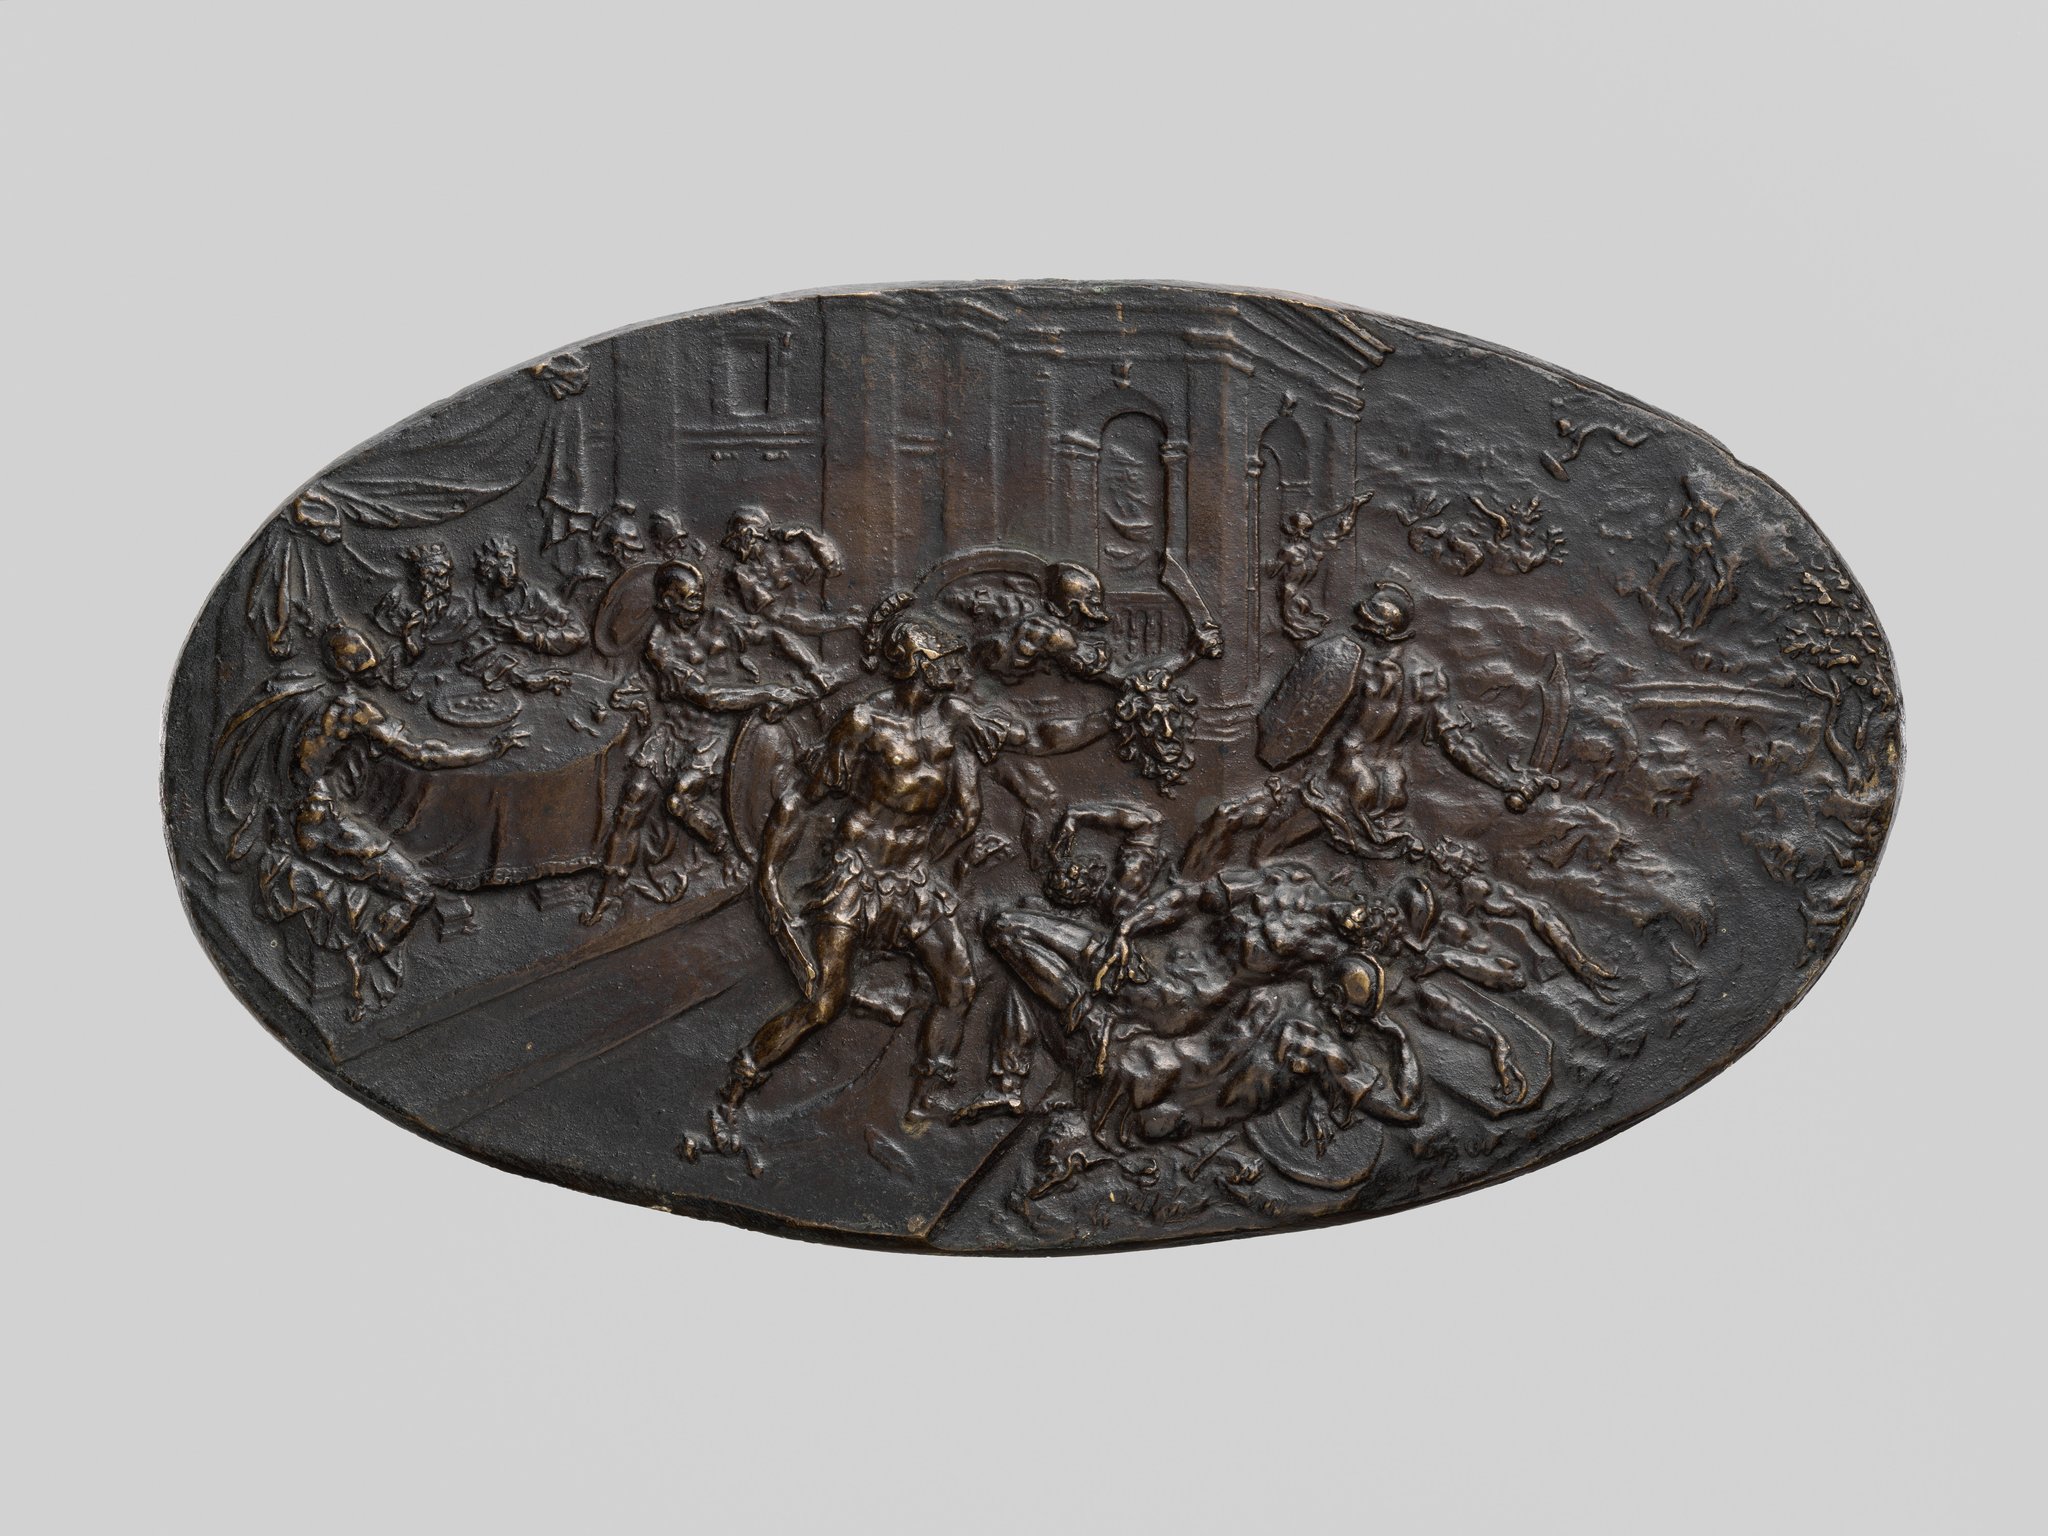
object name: plaquette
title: Perseus with the head of Medusa, and Phineus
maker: guglielmo della porta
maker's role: artist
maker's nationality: italian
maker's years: 1500-1577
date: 1501-1600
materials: bronze, patina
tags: kings,medusa,perseus